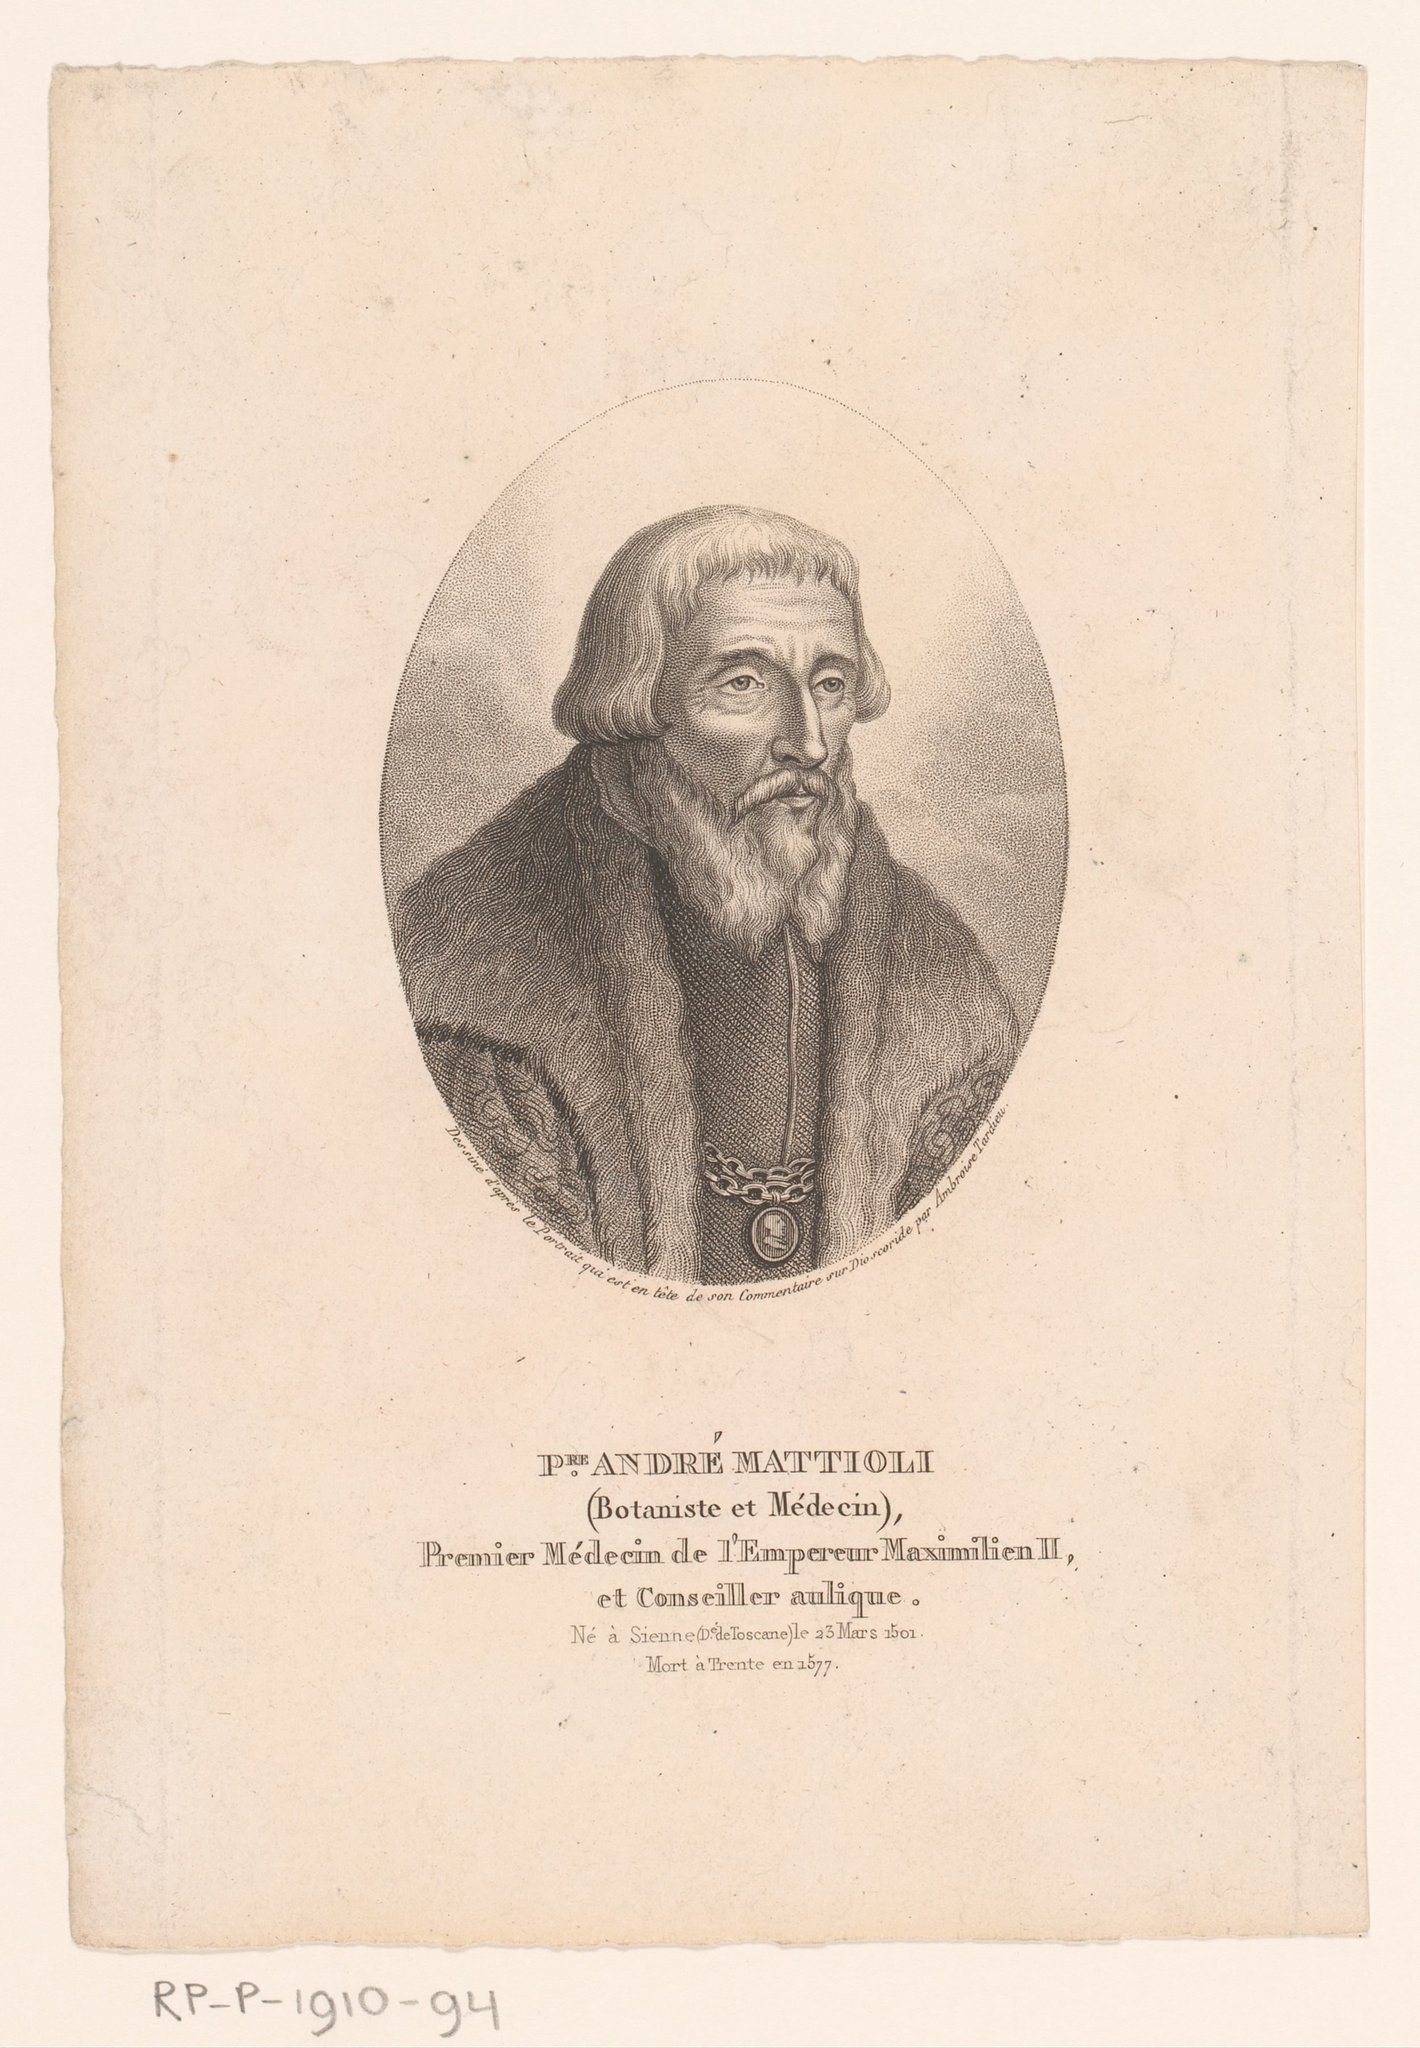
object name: print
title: Portret van Pietro Andrea Mattioli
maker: ambroise tardieu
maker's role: print maker, printer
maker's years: 1788-1841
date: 1820-1828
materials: paper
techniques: engraving, roulette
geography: paris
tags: historical persons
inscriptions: collector's mark: Lugt 2228